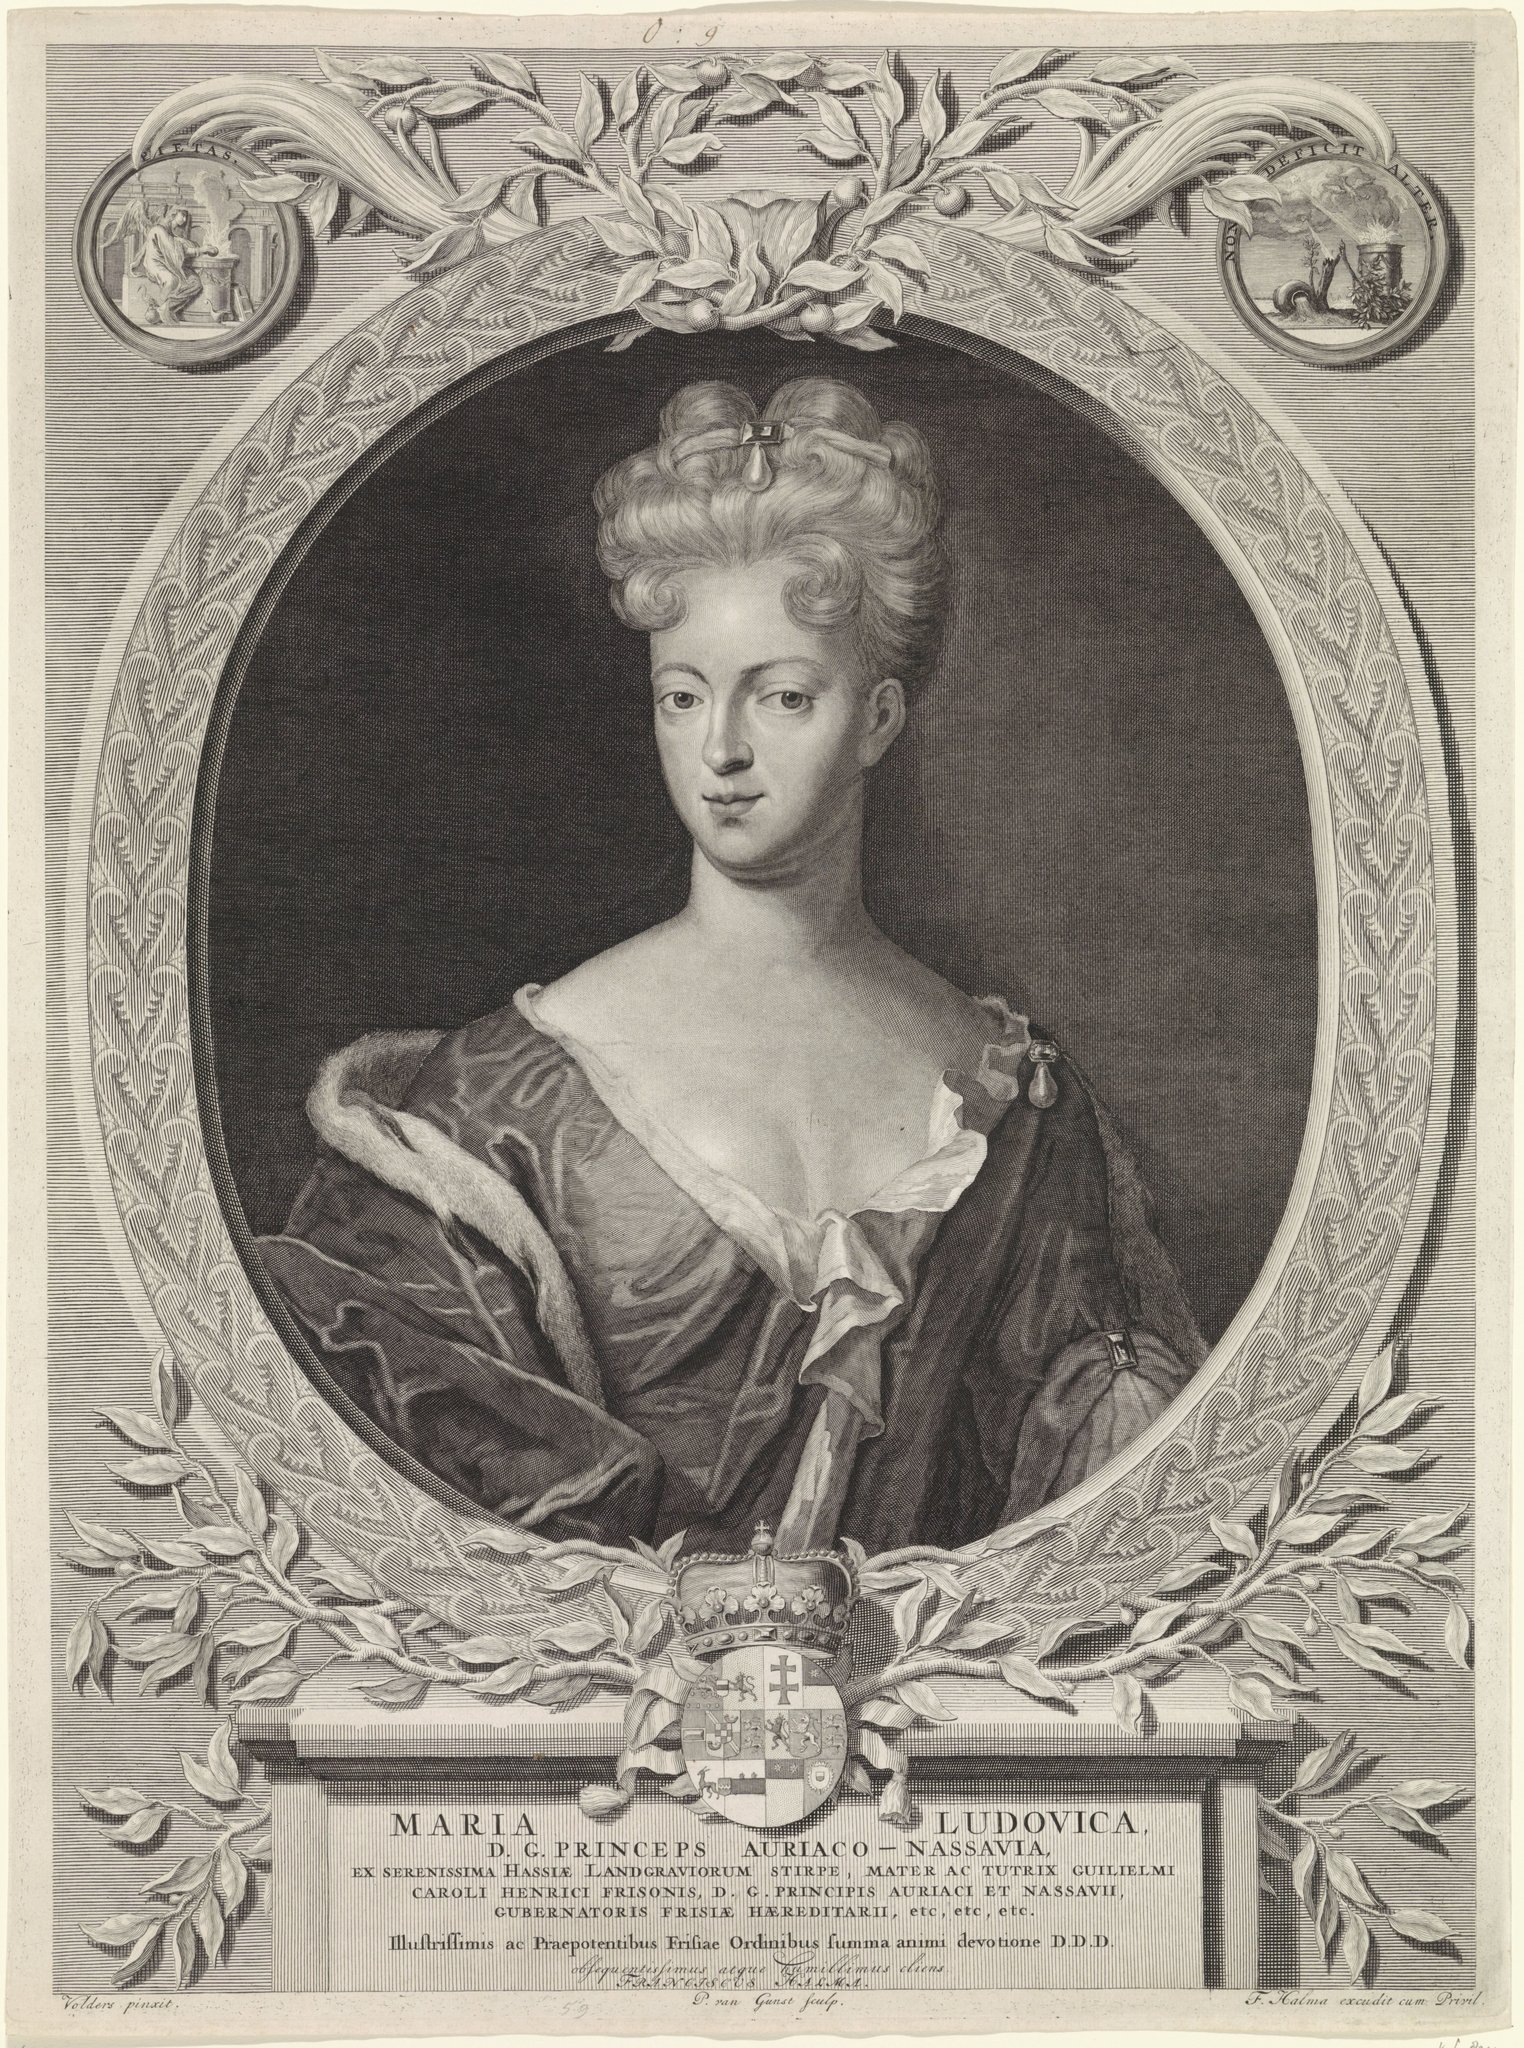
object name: print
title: Portret van Maria Louise, prinses van Oranje-Nassau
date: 1709-1731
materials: paper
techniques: engraving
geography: amsterdam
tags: kassel, maria louisa van hessen-kassel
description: Maria Louise, prinses van Oranje-Nassau en weduwe van Johan Willem Friso, prins van Oranje. Bovenaan twee medaillons met deviezen. Met als onderschrift een Latijns gedicht over haar leven.